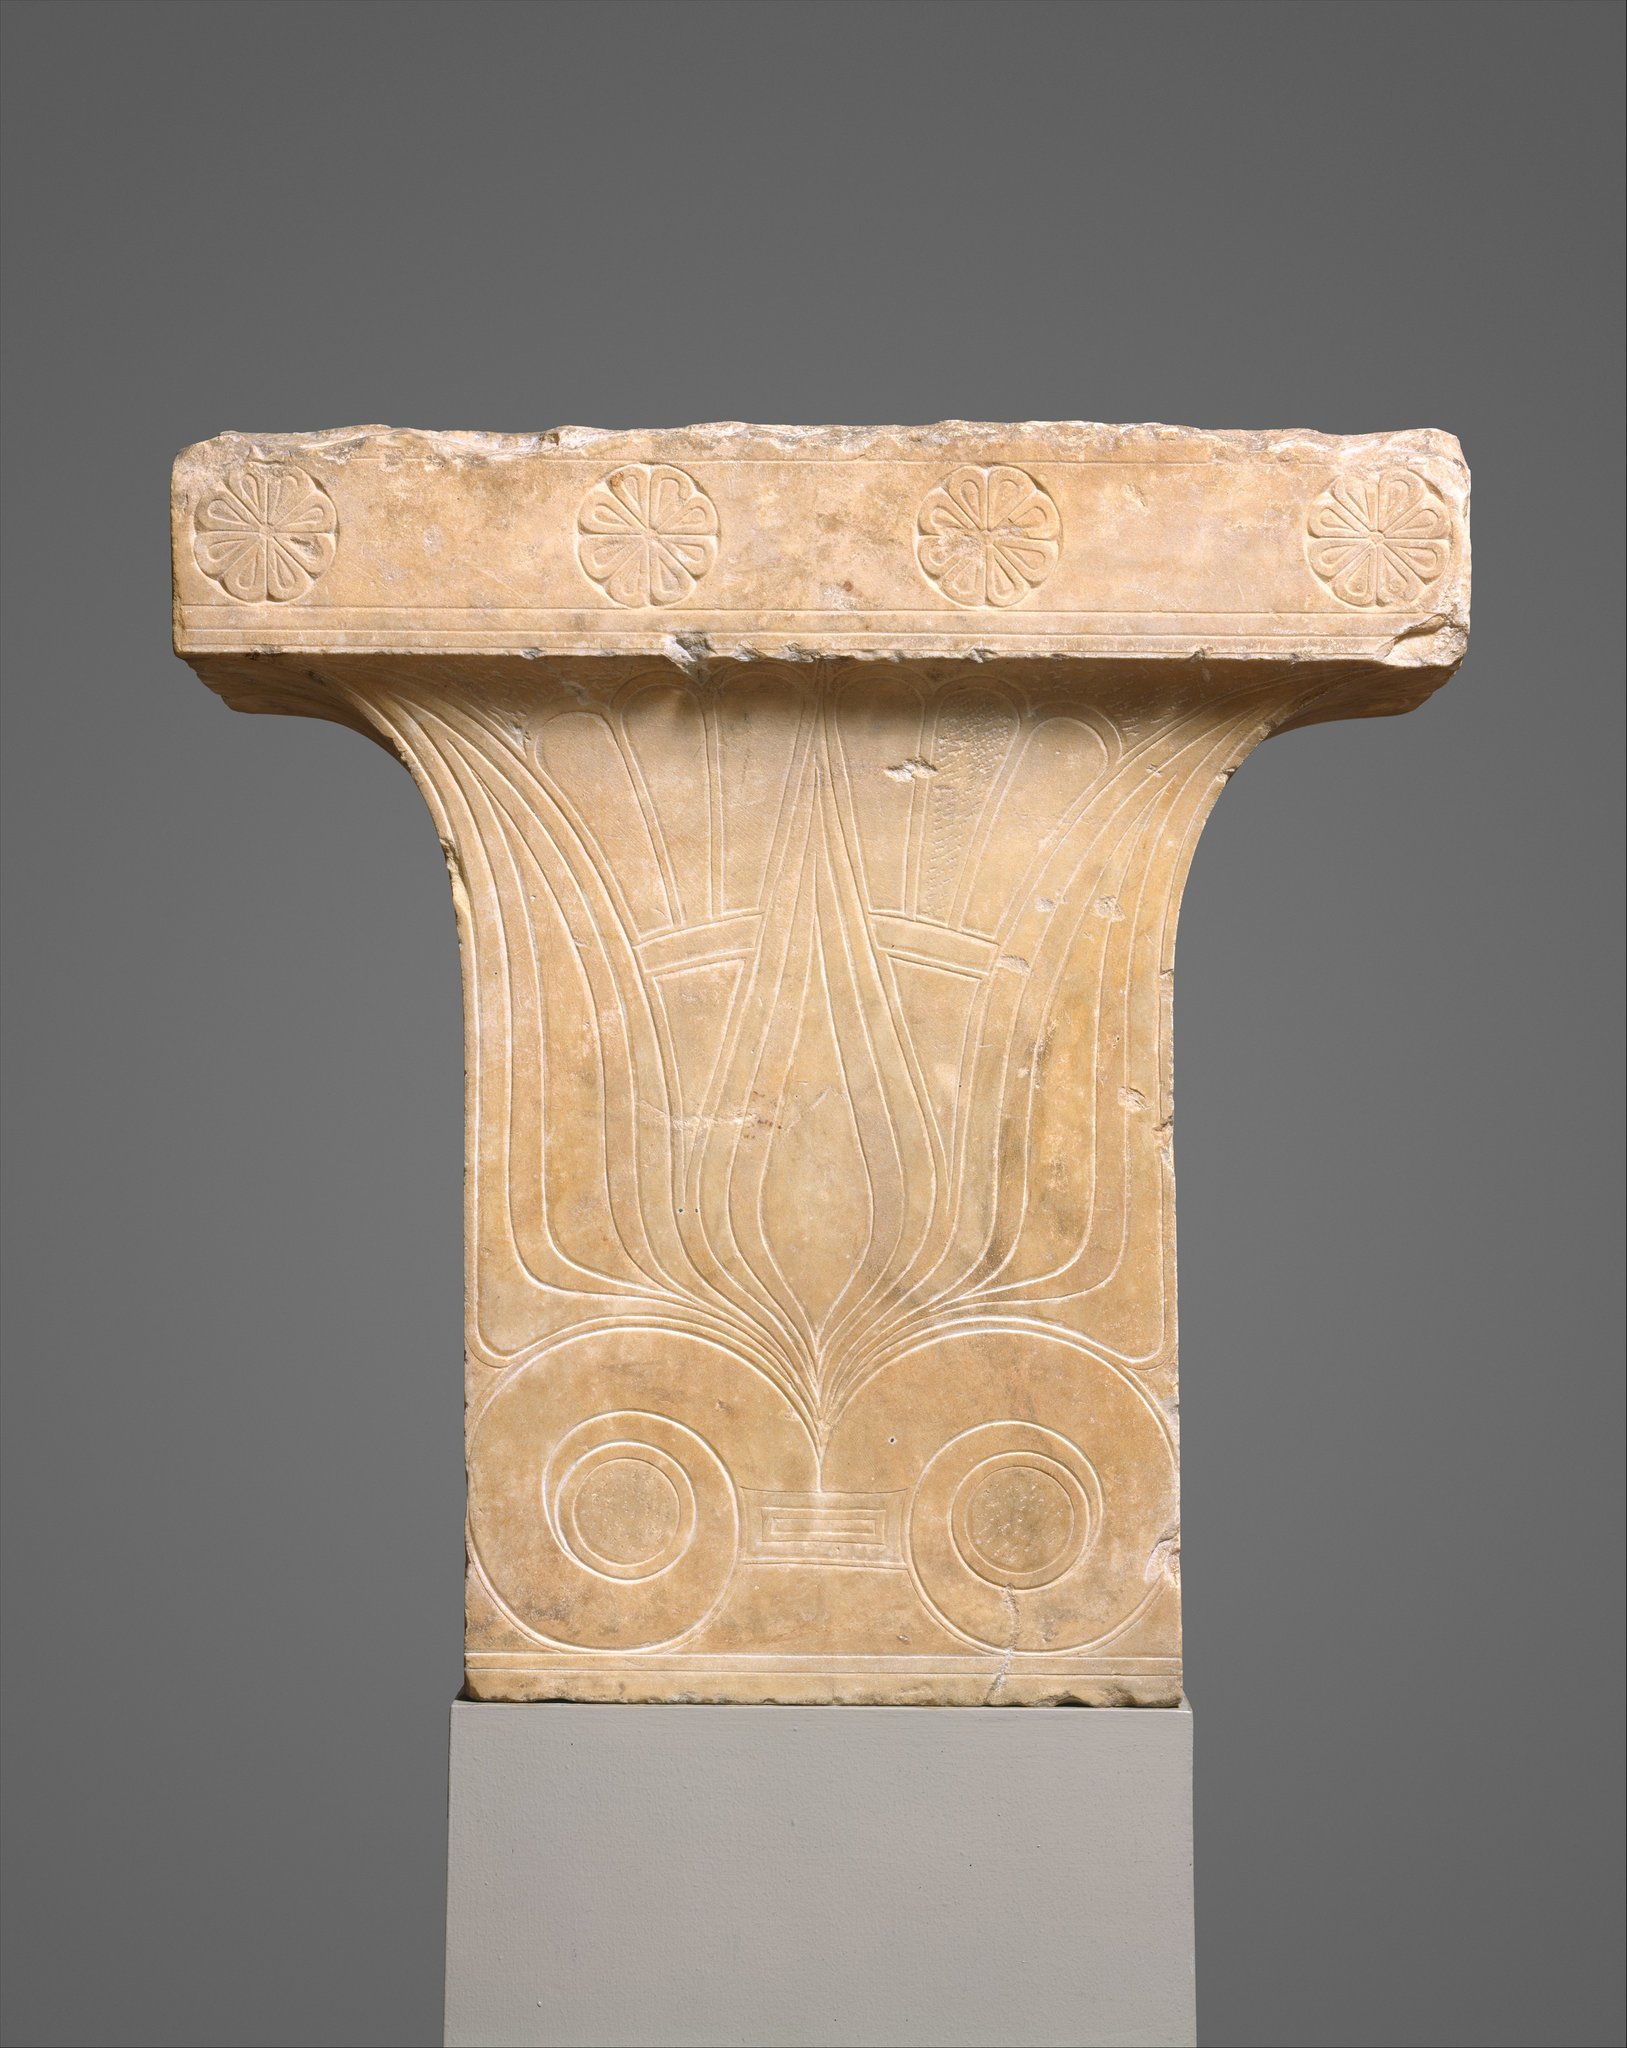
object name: capital, cavetto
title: Marble cavetto capital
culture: greek, attic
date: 567-535 BCE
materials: marble